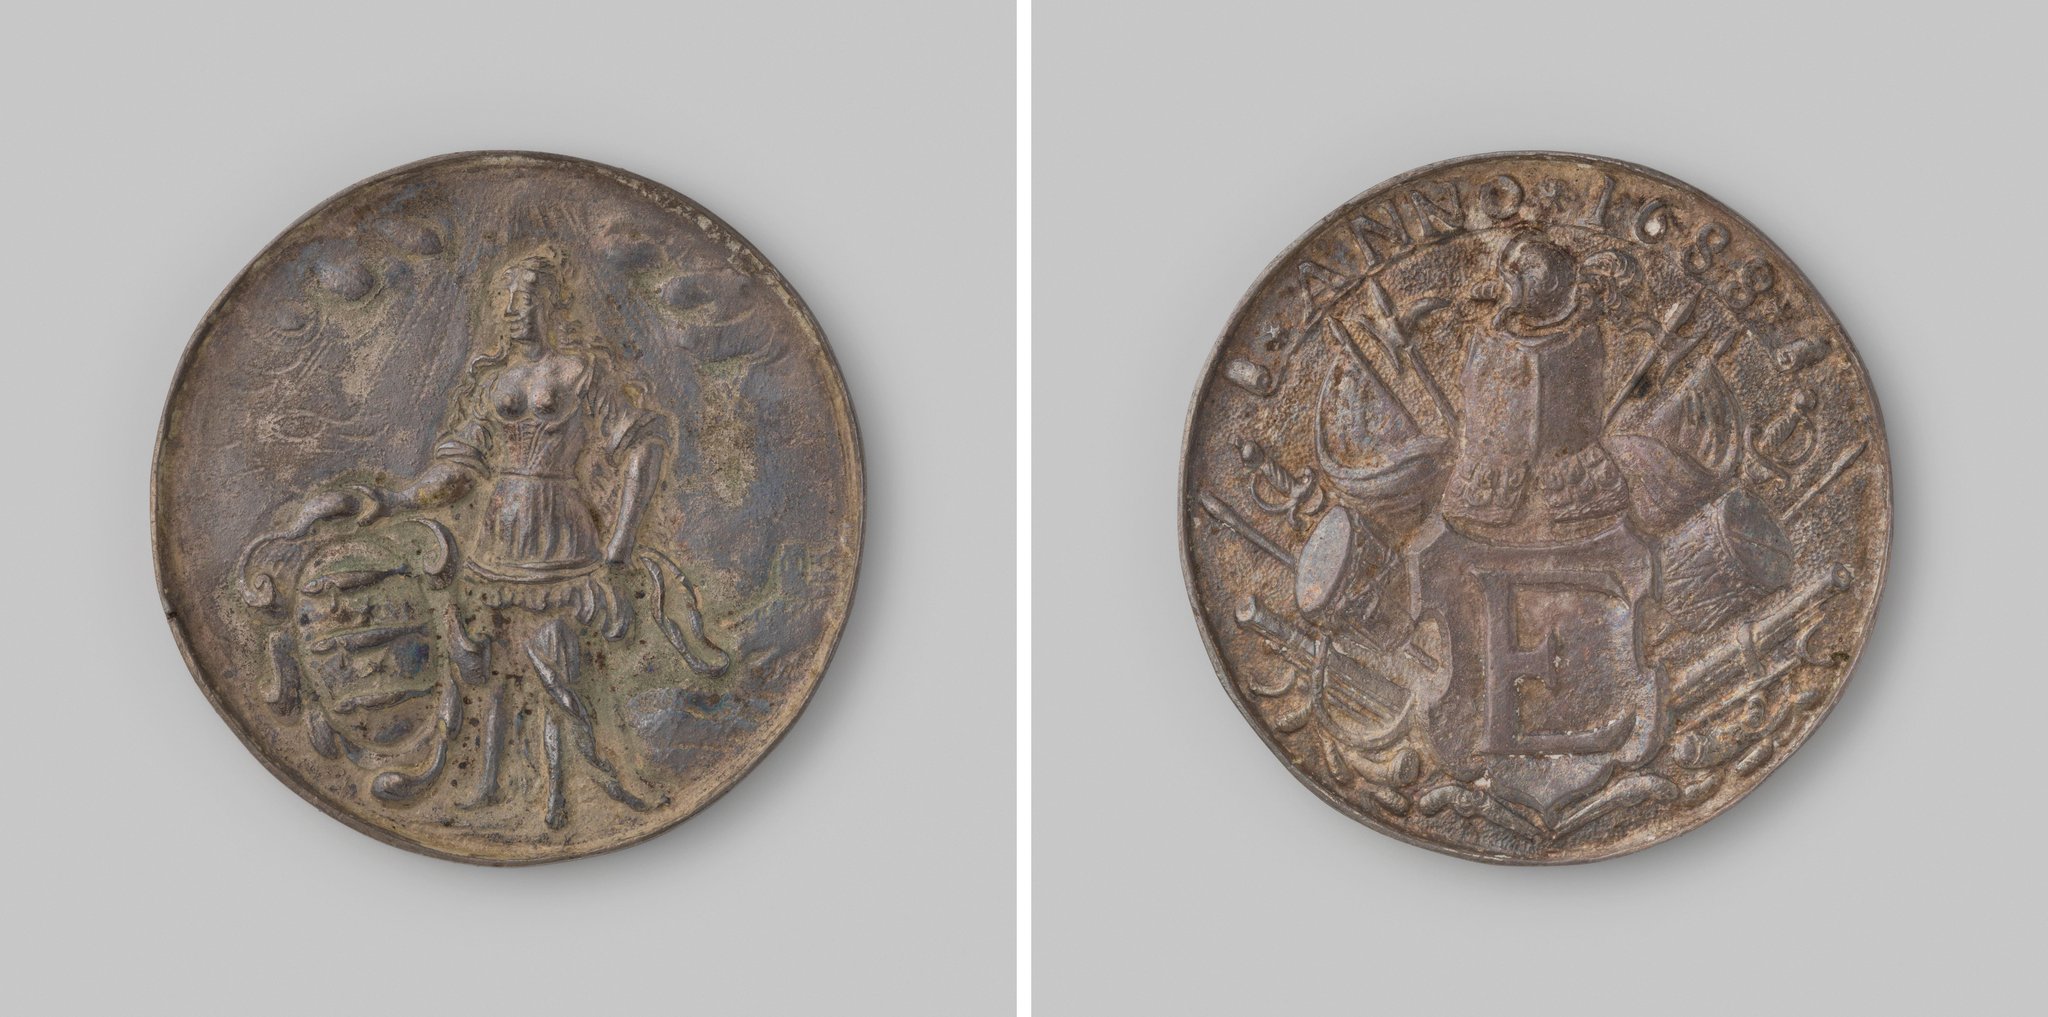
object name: marksman medal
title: Schutterspenning van Enkhuizen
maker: Anonymous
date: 1688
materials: silver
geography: enkhuizen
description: Zilveren schutterspenning van Enkhuizen. Voorzijde: de maagd van Enkhuizen die een wapenschild van de stad vasthoudt. Zonnestralen die door de wolken breken, met de vestingwerken van de stad in het verschiet. Keerzijde: een grote trofee waarvoor een schild staat met de letter E. Bovenaan staat in een banderol: Anno 1688.